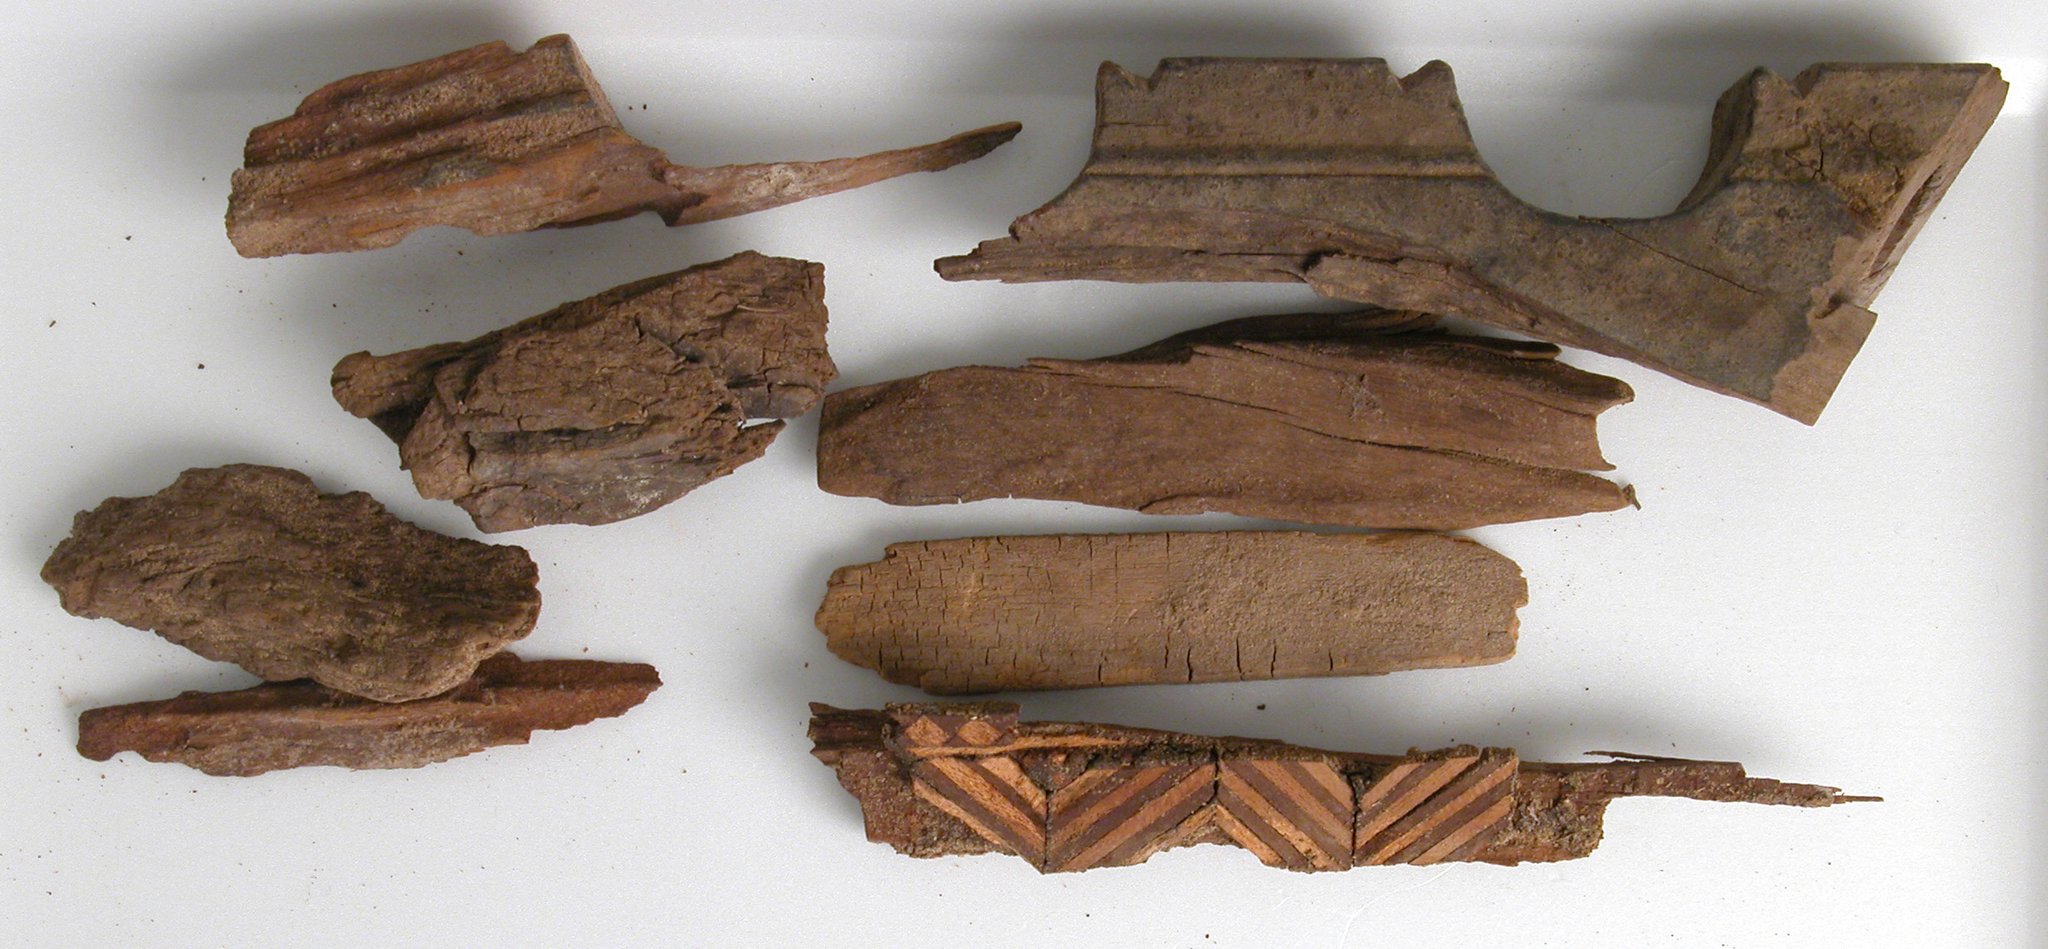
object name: fragment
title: Wood Fragments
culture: coptic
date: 301-700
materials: wood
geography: egypt